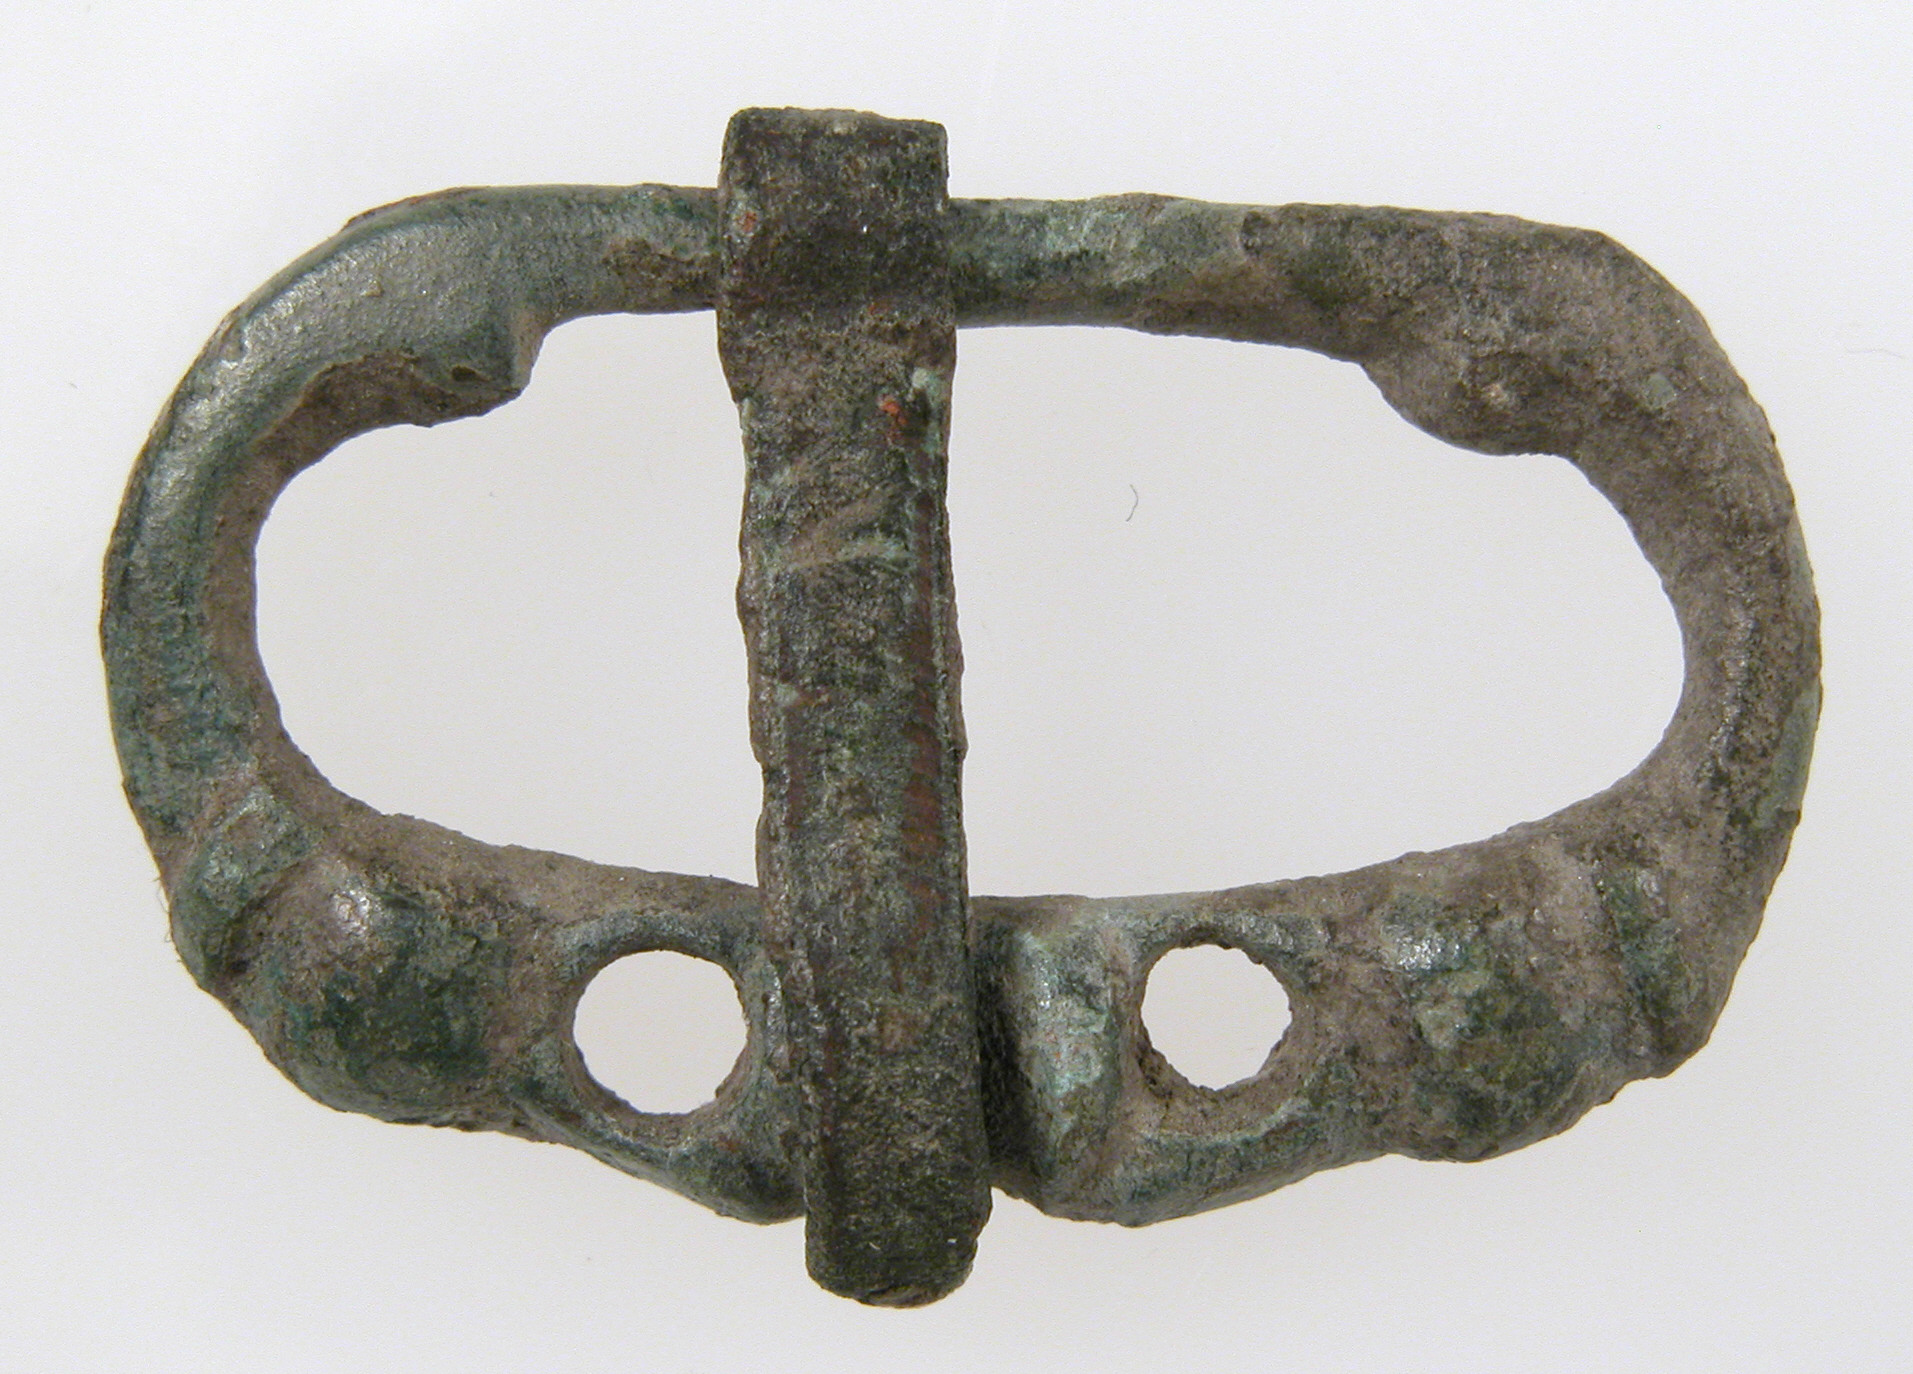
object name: buckle loop and tongue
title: Loop and Tongue of a Buckle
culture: viking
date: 701-800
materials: copper alloy